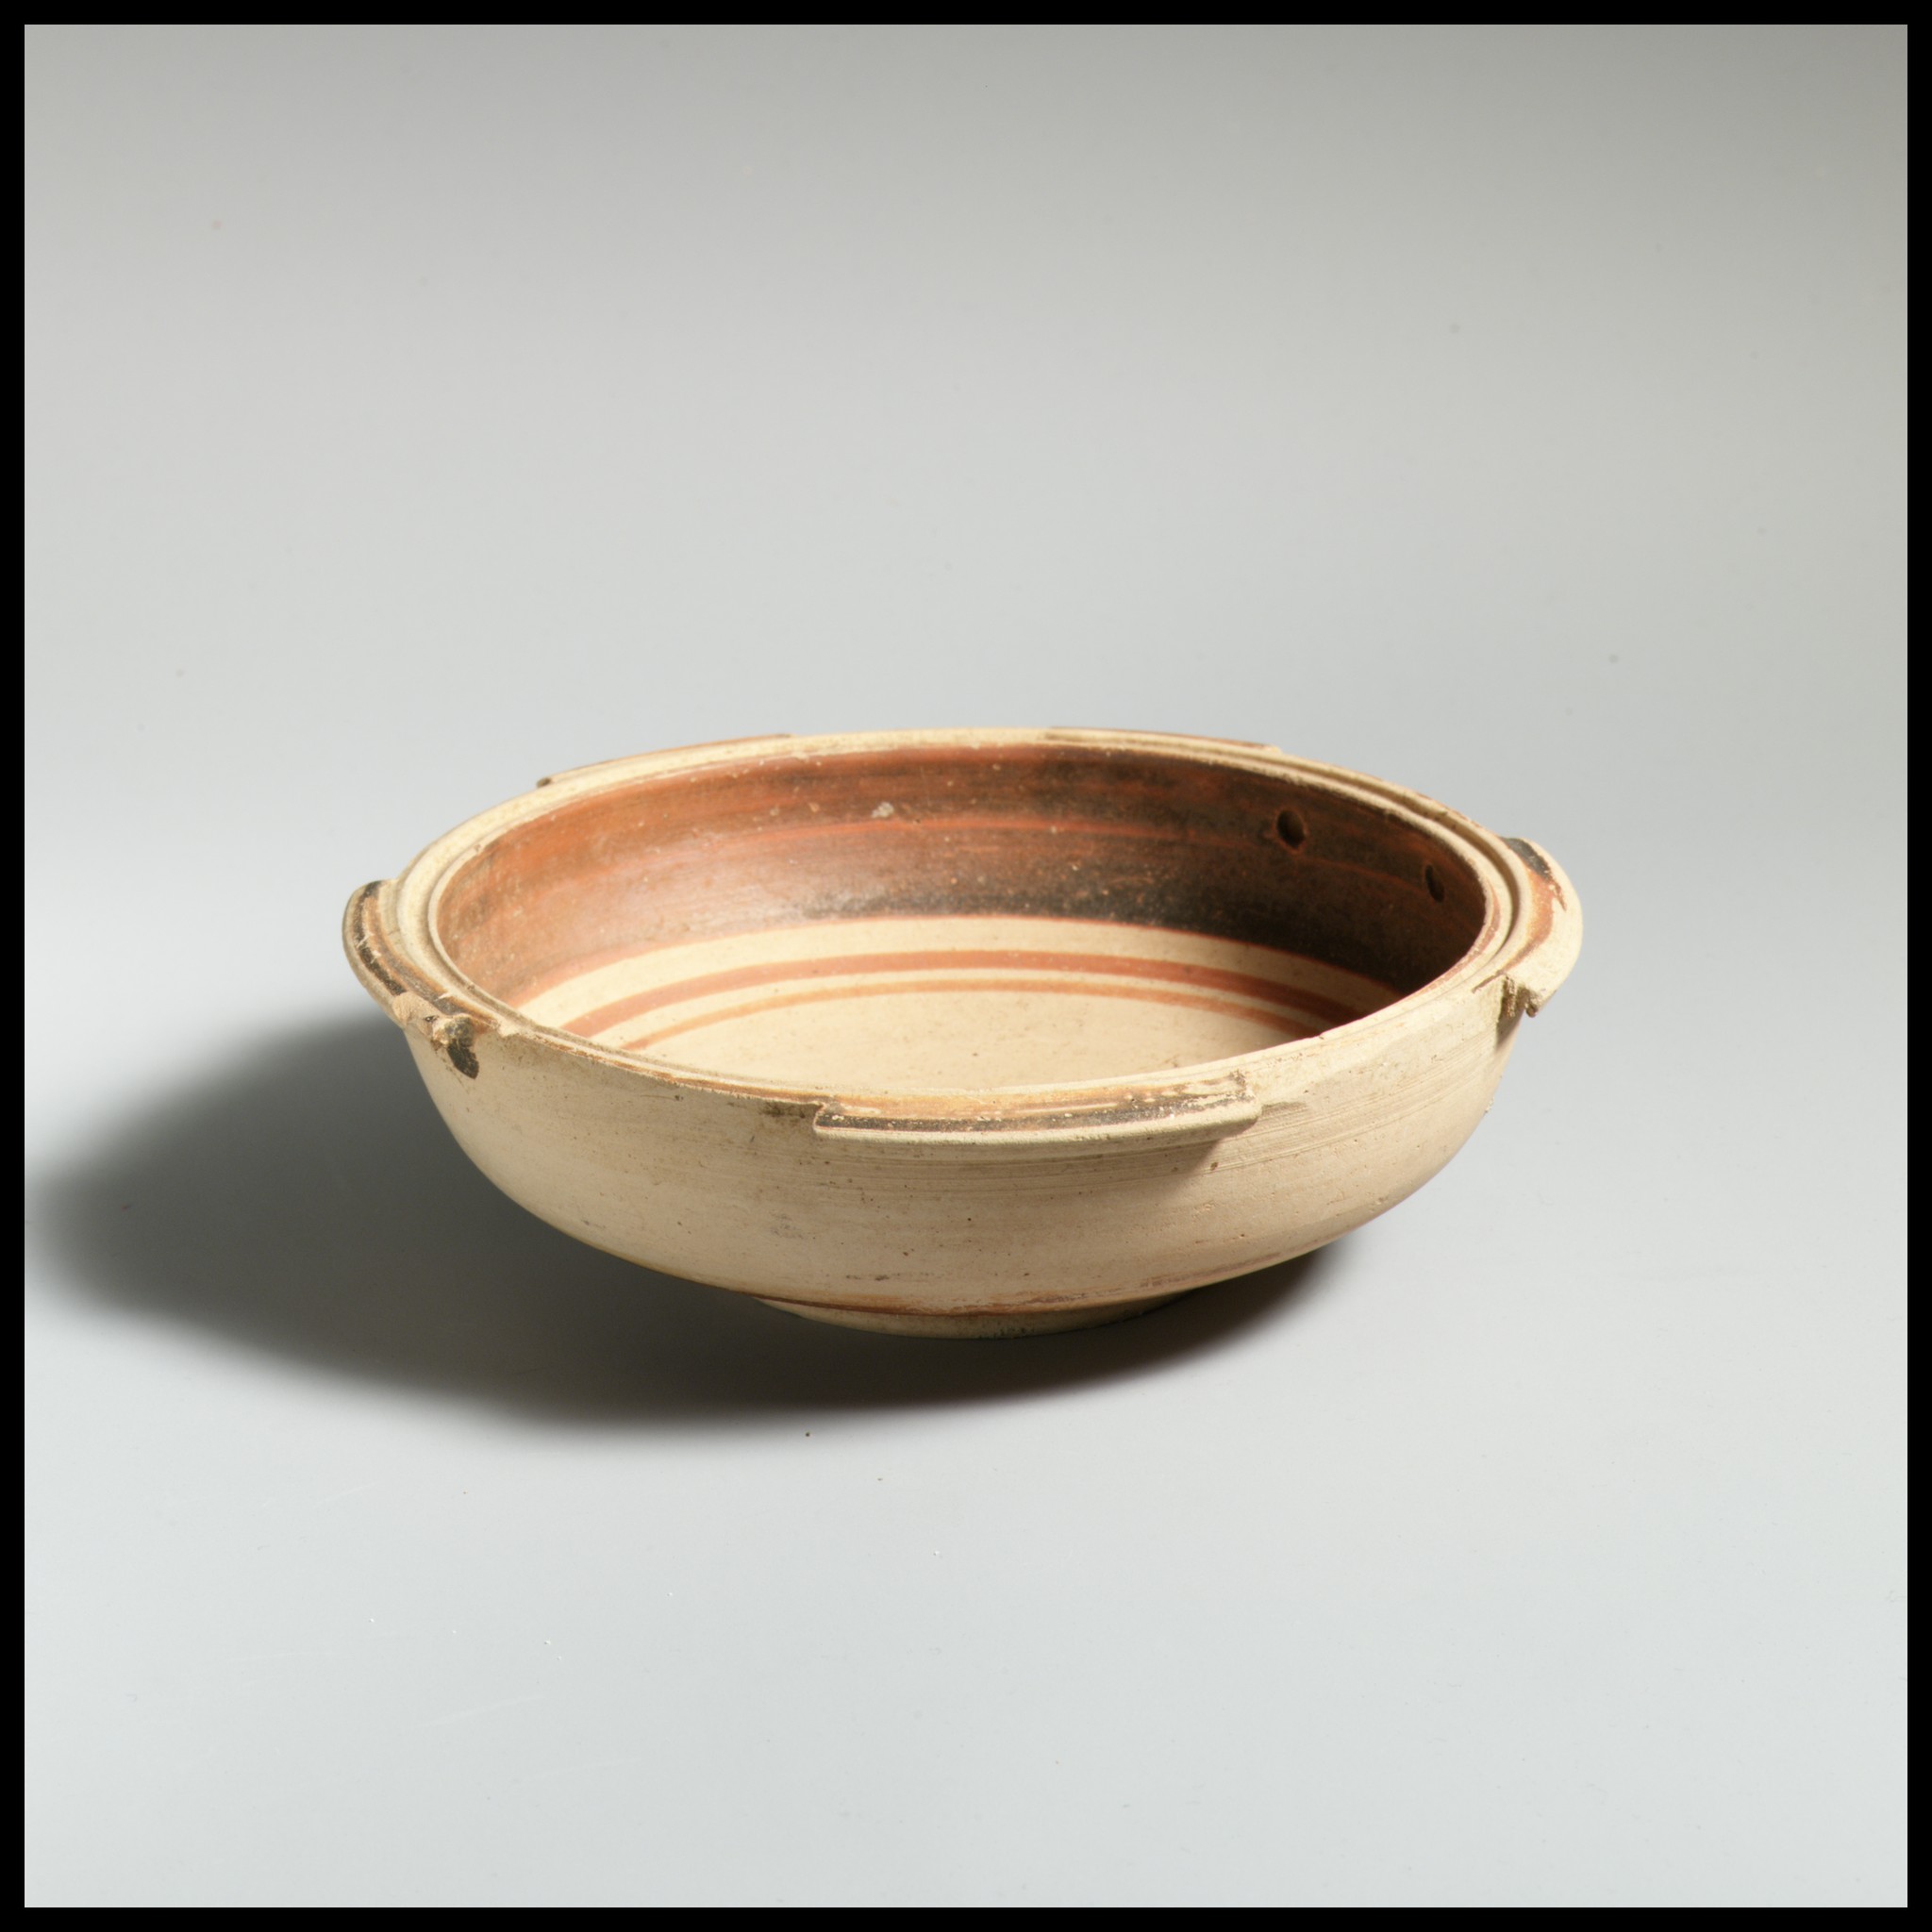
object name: bowl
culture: italic, daunian or south italian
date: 550-450 BCE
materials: terracotta